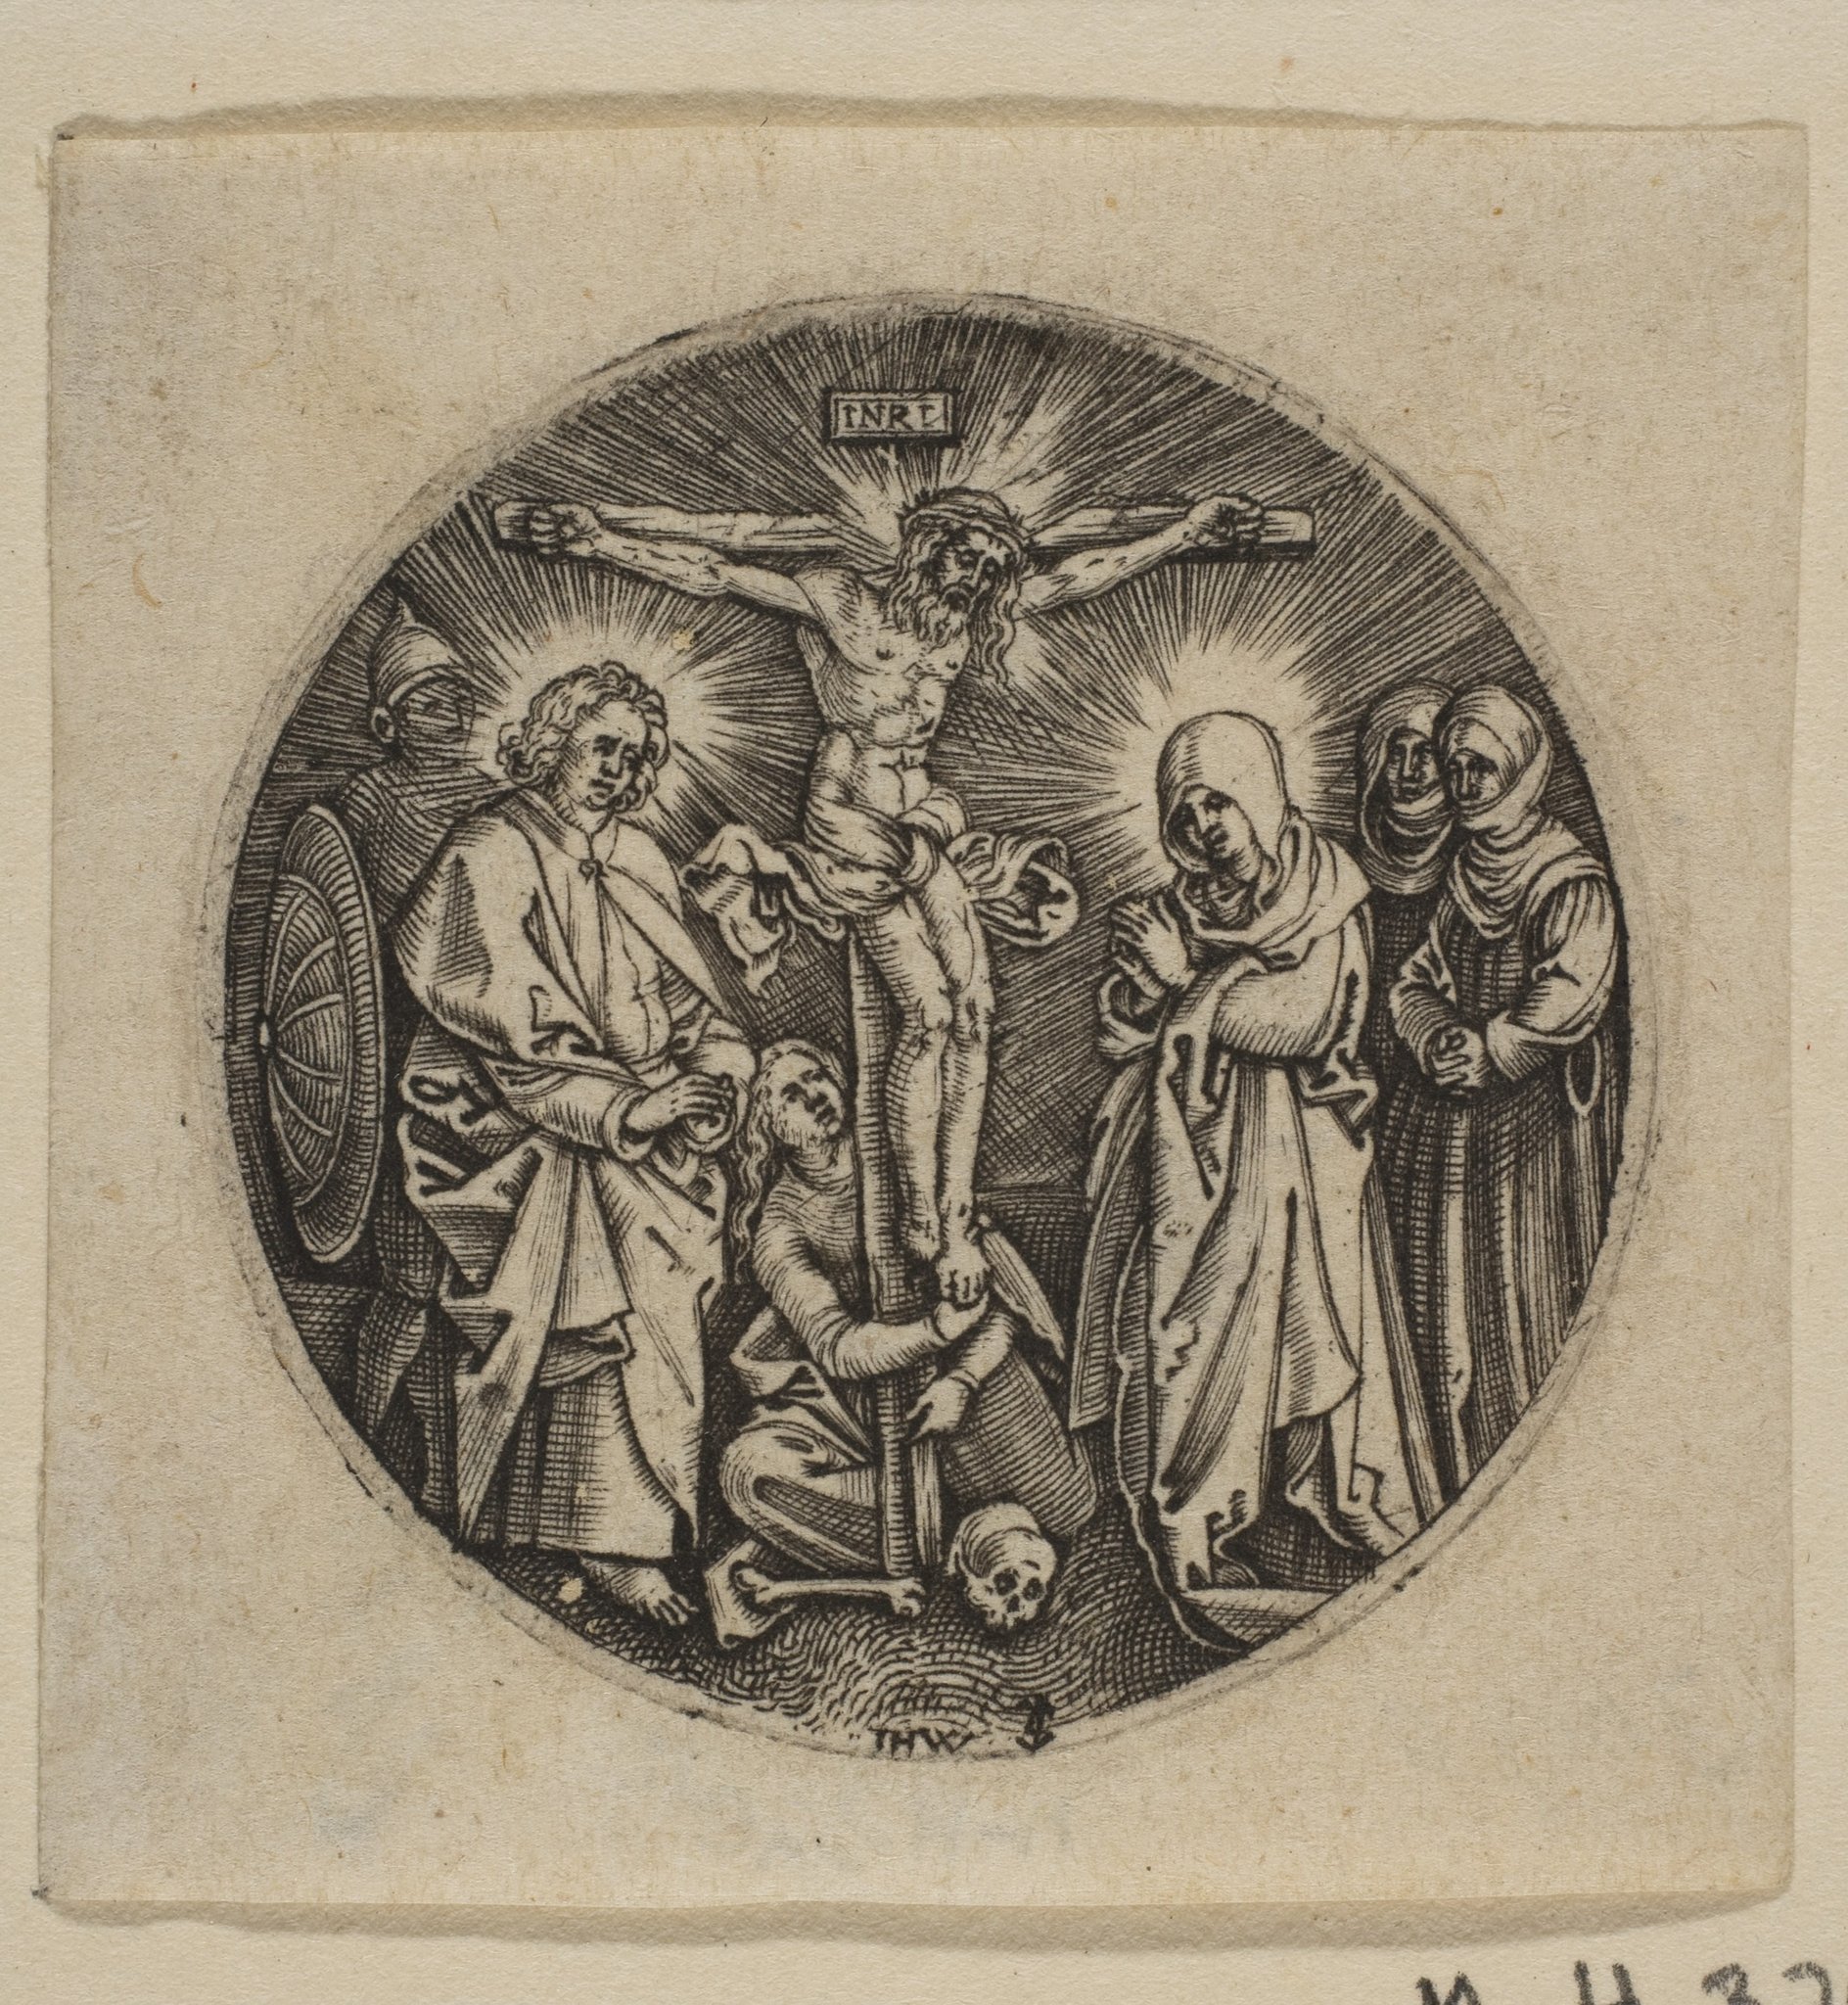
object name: print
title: The Crucifixion (Round) (copy)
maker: jan (johannes) wierix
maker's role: artist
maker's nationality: netherlandish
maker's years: 1549-1615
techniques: engraving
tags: christ,cross,crucifixion,saints